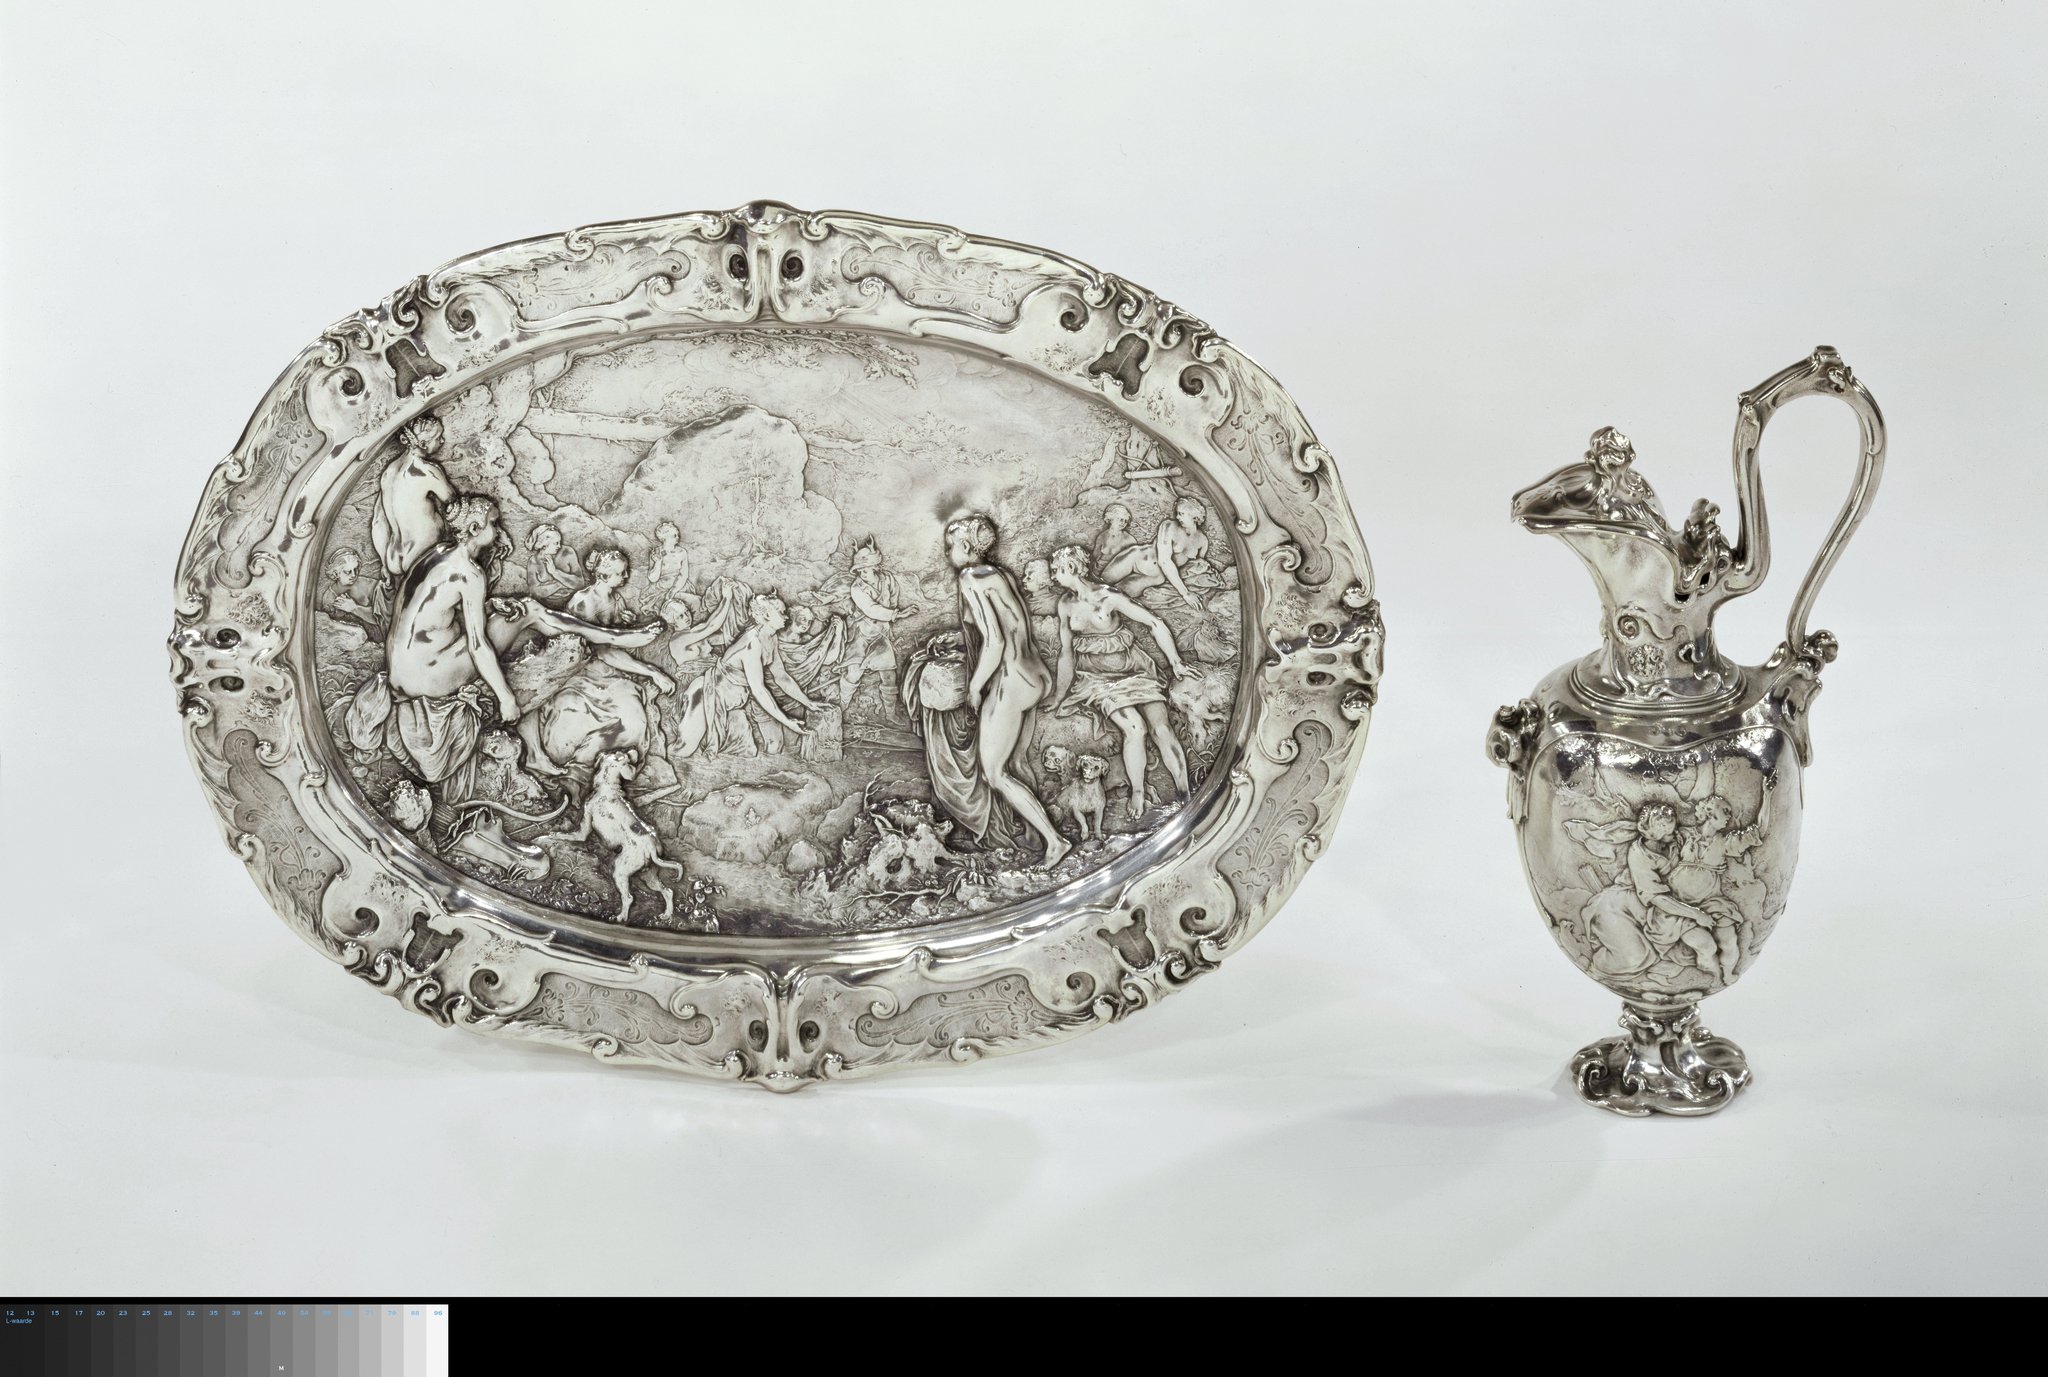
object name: ewer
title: Ewer with Scenes from the Story of Diana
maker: paulus willemsz. van vianen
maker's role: draughtsman, jeweler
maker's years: 1570-1614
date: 1613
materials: silver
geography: prague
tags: jupiter, in the guise of diana, and callisto, auricular ornament, lobe style ~ ornament, homosexual love - cc - homosexual love between women: lesbianism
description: The ewer forms a set with the adjacent basin. They are the last works by Paulus van Vianen, who died in 1613. These objects were not made to be used but rather to be admired as works of art. The small, asymmetrical foot is unstable, and the handle highly impractical. The ewer and basin were bought by a Dutchman in Prague who took them to the Netherlands.